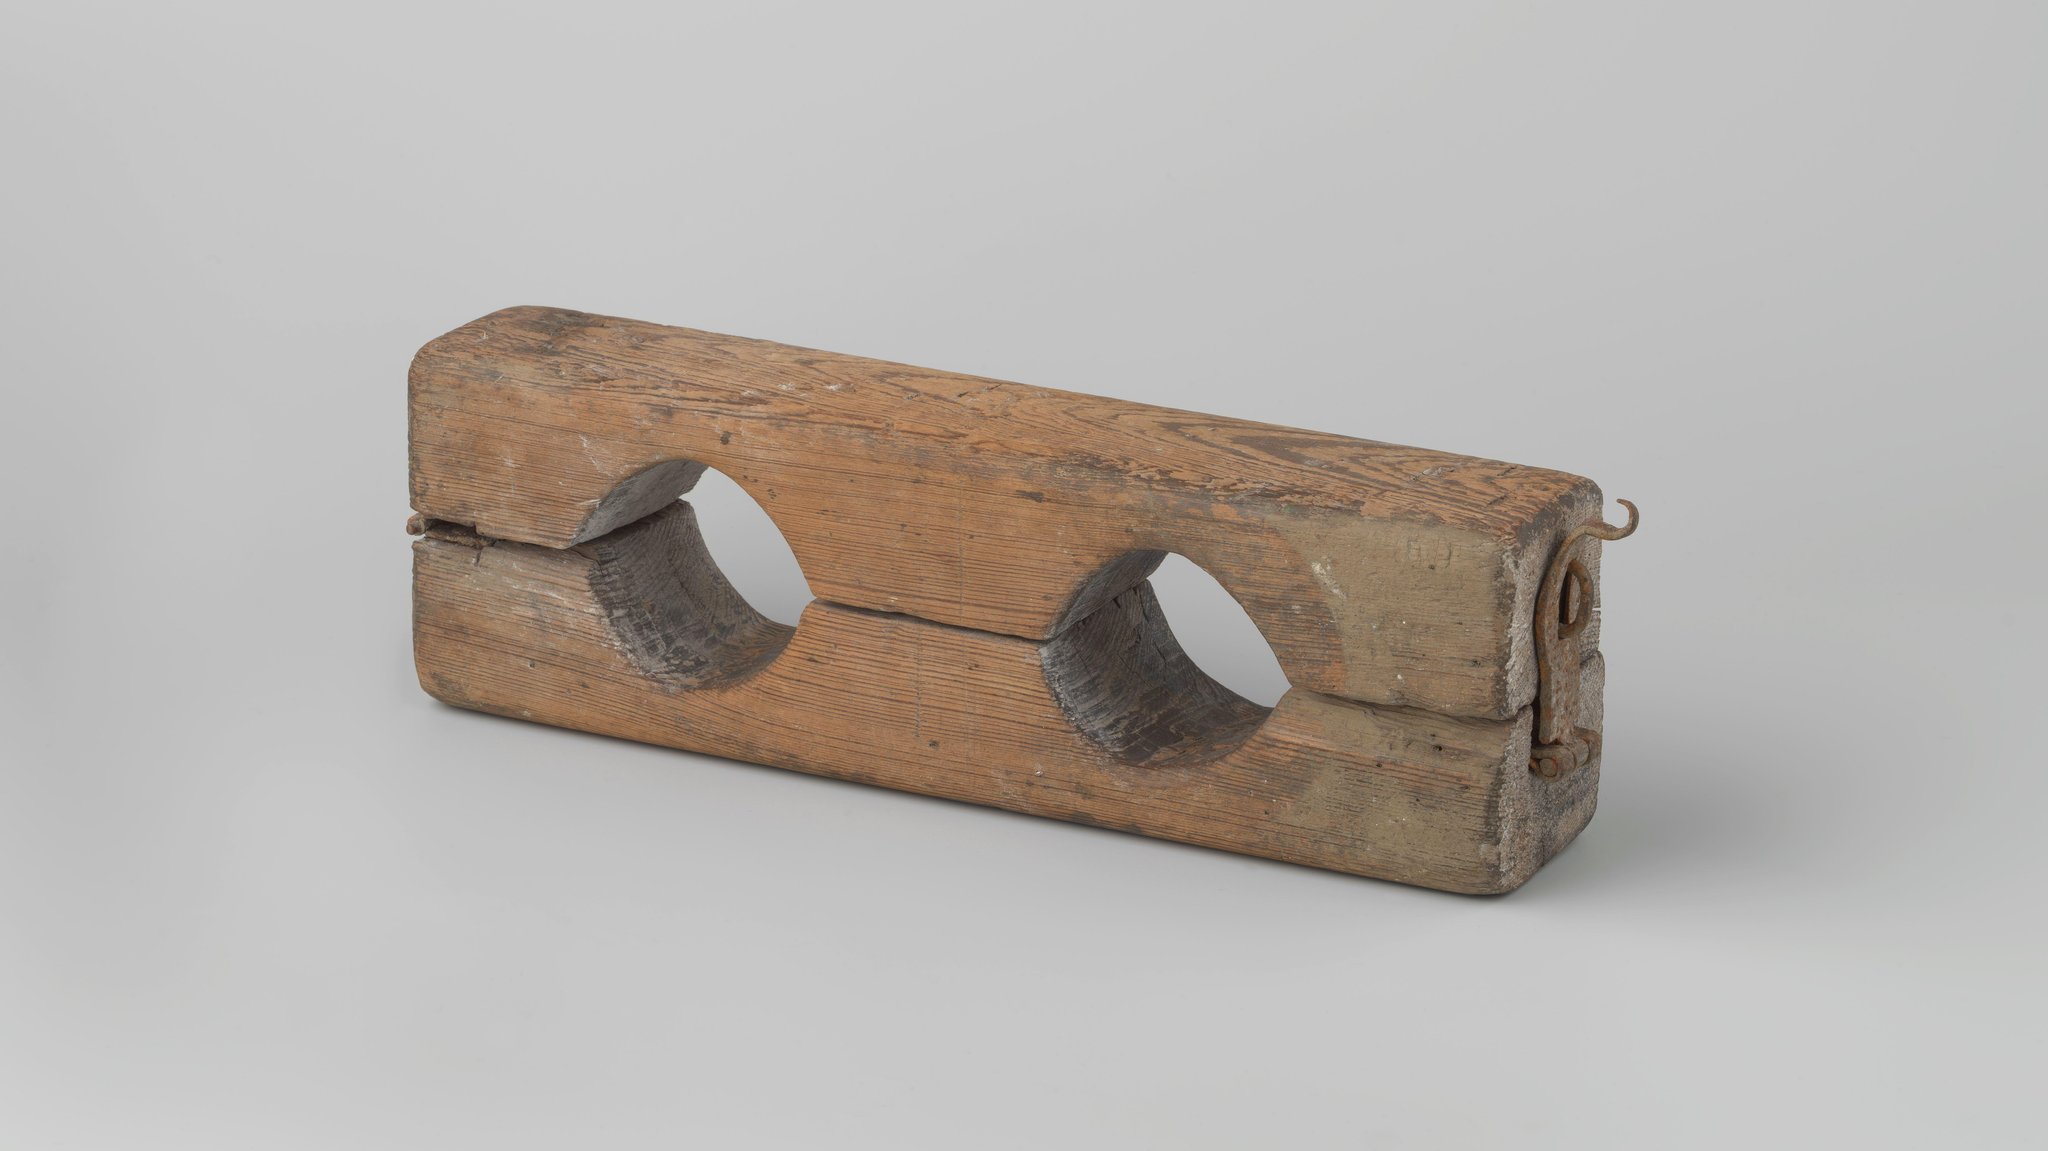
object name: slavenboei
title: Legcuff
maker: Anonymous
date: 1800-1899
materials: iron, wood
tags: slavery; serfs and enslaved persons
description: Enslaved people were considered the property of the slave owner. This Curaçao legcuff was used to punish or prevent them from fleeing. One of the enslaved people on Curaçao was Tula. Inspired by the French Revolution, he stated, ‘French slaves gained their freedom, Holland was occupied by the French, then we too must be free here.’ Tula’s call led to the largest slave revolt in the Netherlands Antilles.